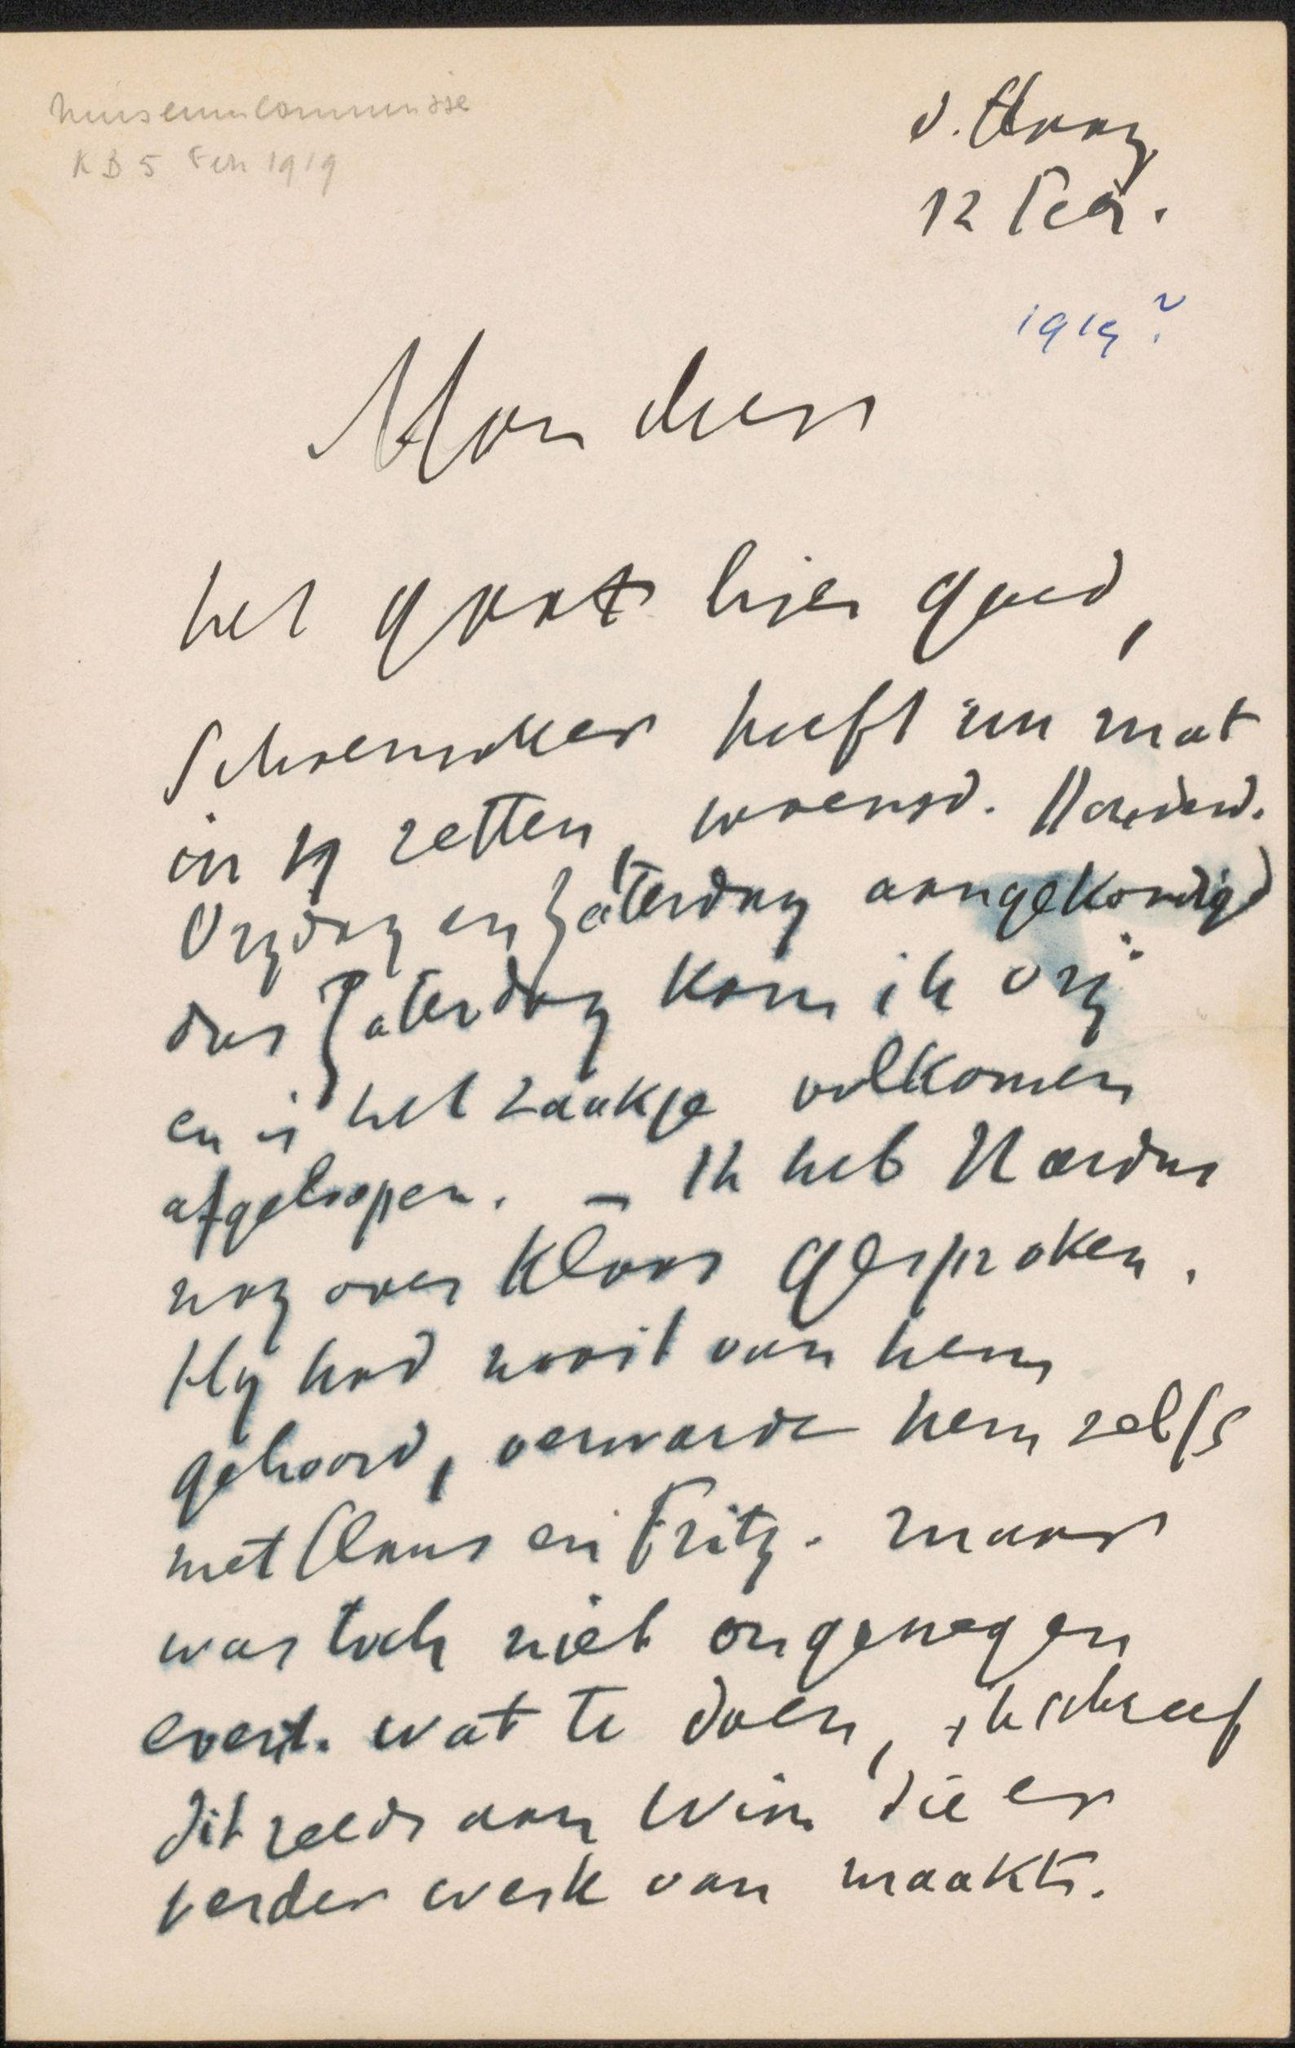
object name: letter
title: Brief aan Jan Veth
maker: isaac israels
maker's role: draughtsman, painter, print maker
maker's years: 1865-1934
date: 1875-1925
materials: ink, paper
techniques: pen, writing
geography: the hague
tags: utrecht, dordrecht, designer, jan veth, amsterdam, painter, print maker, draughtsman, willem witsen, the hague, willem kloos, haarlem, art trade, art shop, historical persons (portraits and scenes from the life)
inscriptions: collector's mark: ‘RPK’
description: Gedateerd 12 februari. In latere hand 1919.